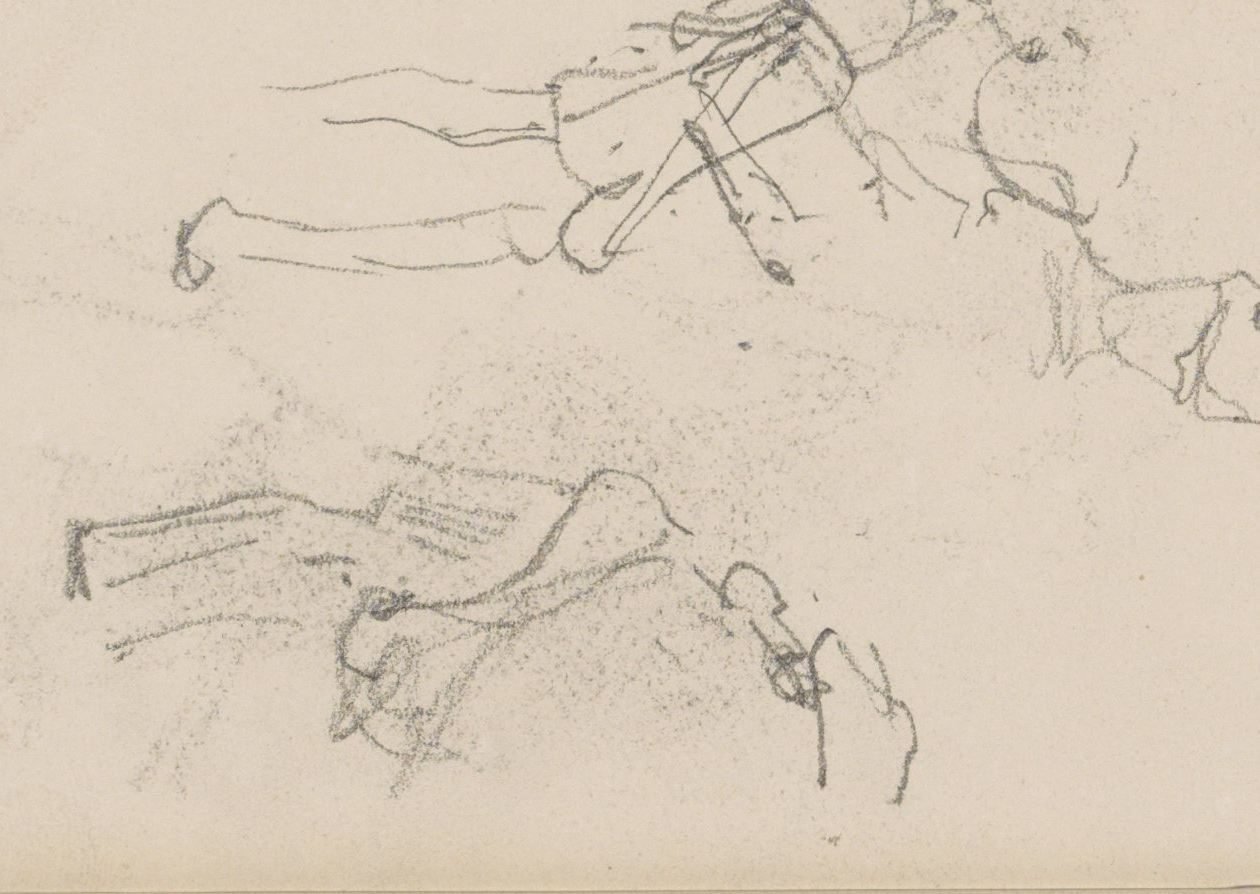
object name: sketchbook leaf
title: Figuurstudies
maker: george hendrik breitner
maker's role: draughtsman, painter, print maker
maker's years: 1857-1923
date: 1880-1882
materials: paper, pencil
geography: the hague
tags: standing figure, adult man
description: Blad 17 verso uit een schetsboek met 16 bladen.